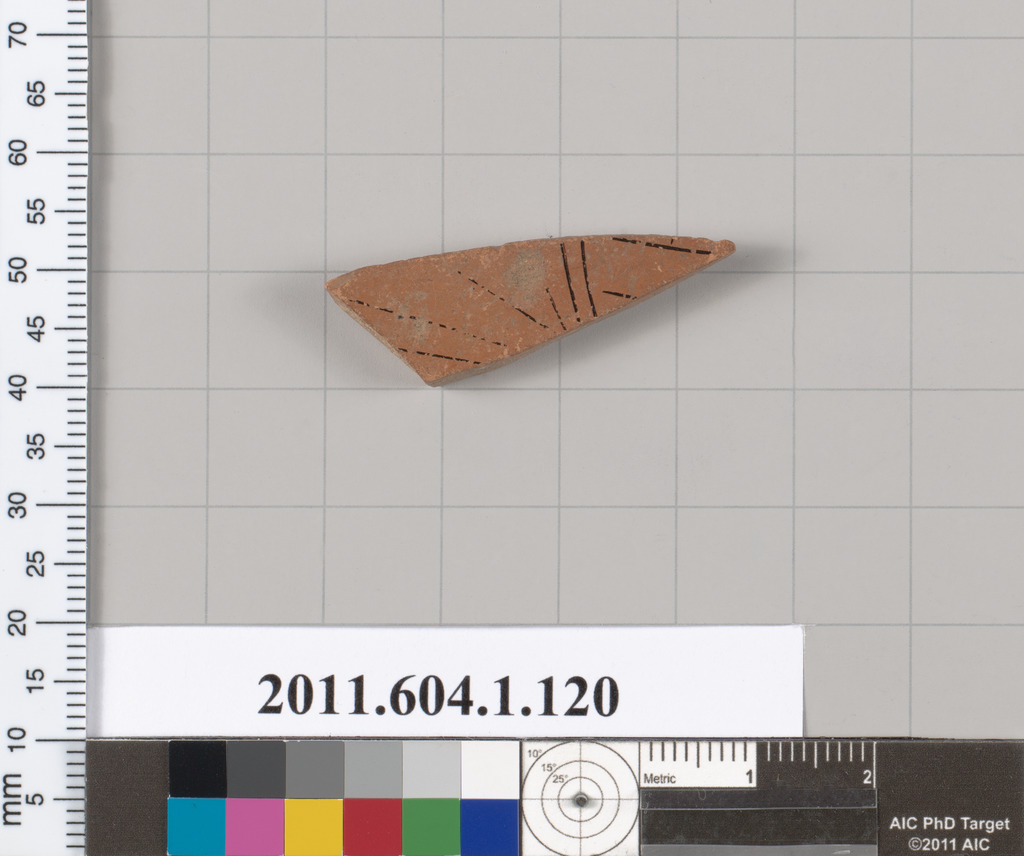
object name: kylix fragment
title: Terracotta fragment of a kylix (drinking cup)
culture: greek, attic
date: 470-450 BCE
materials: terracotta